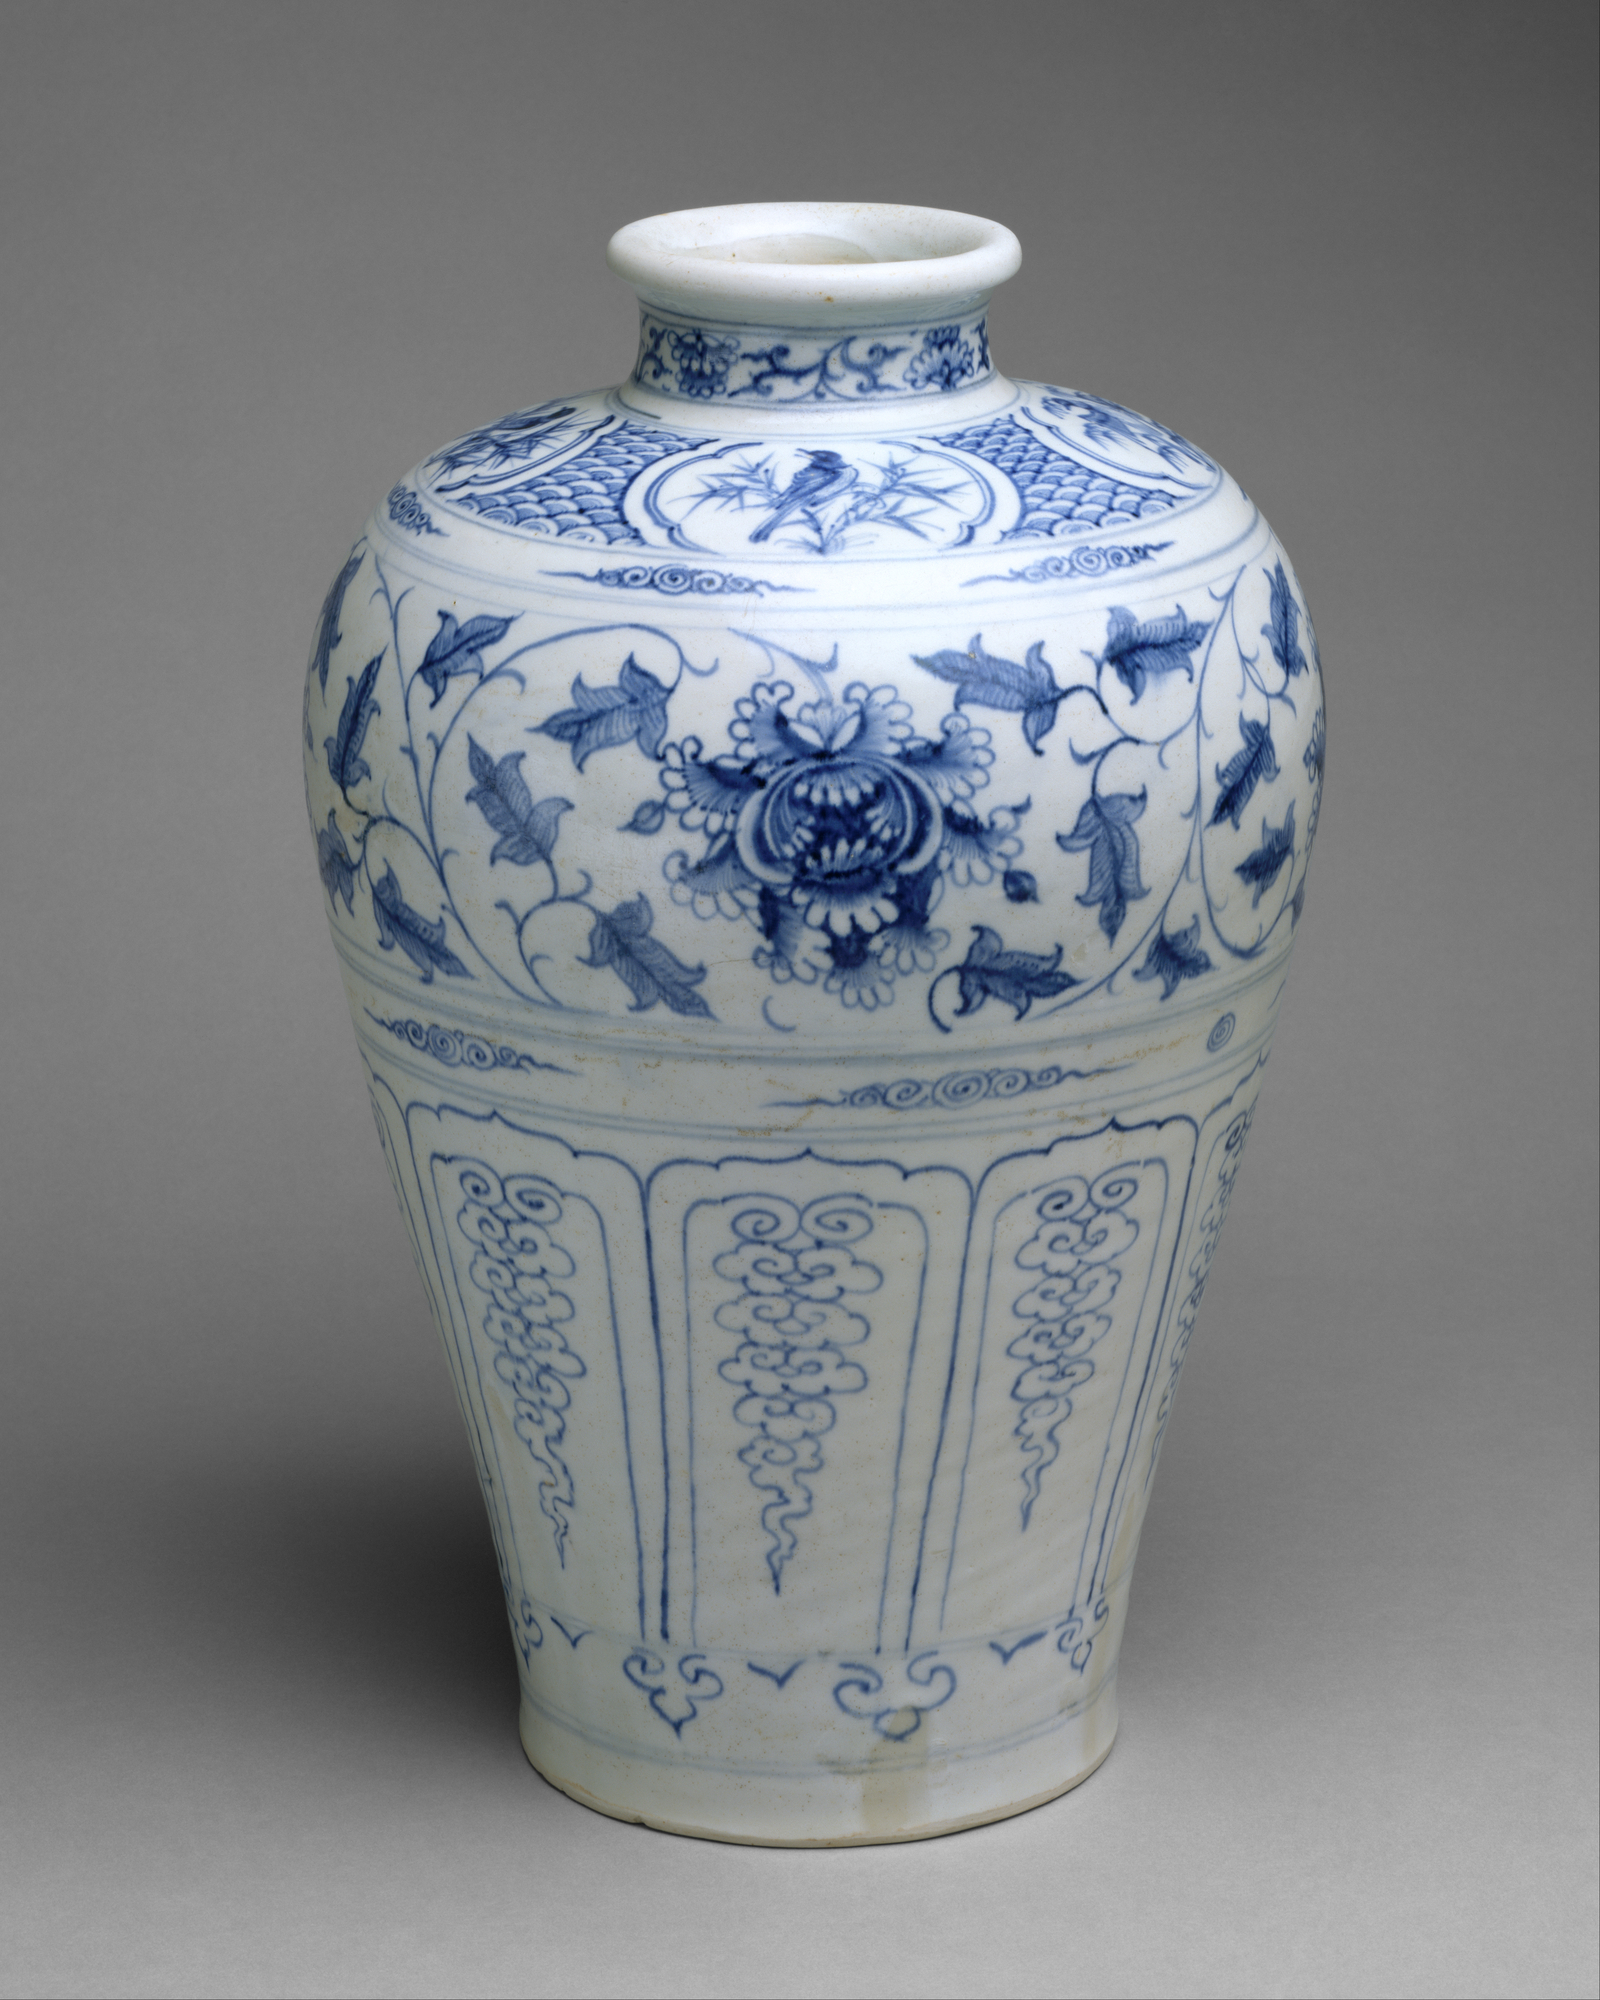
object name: bottle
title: Bottle with Birds and Peony Scroll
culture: vietnamese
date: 1401-1500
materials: cobalt, glaze, stoneware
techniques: painting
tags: birds,flowers